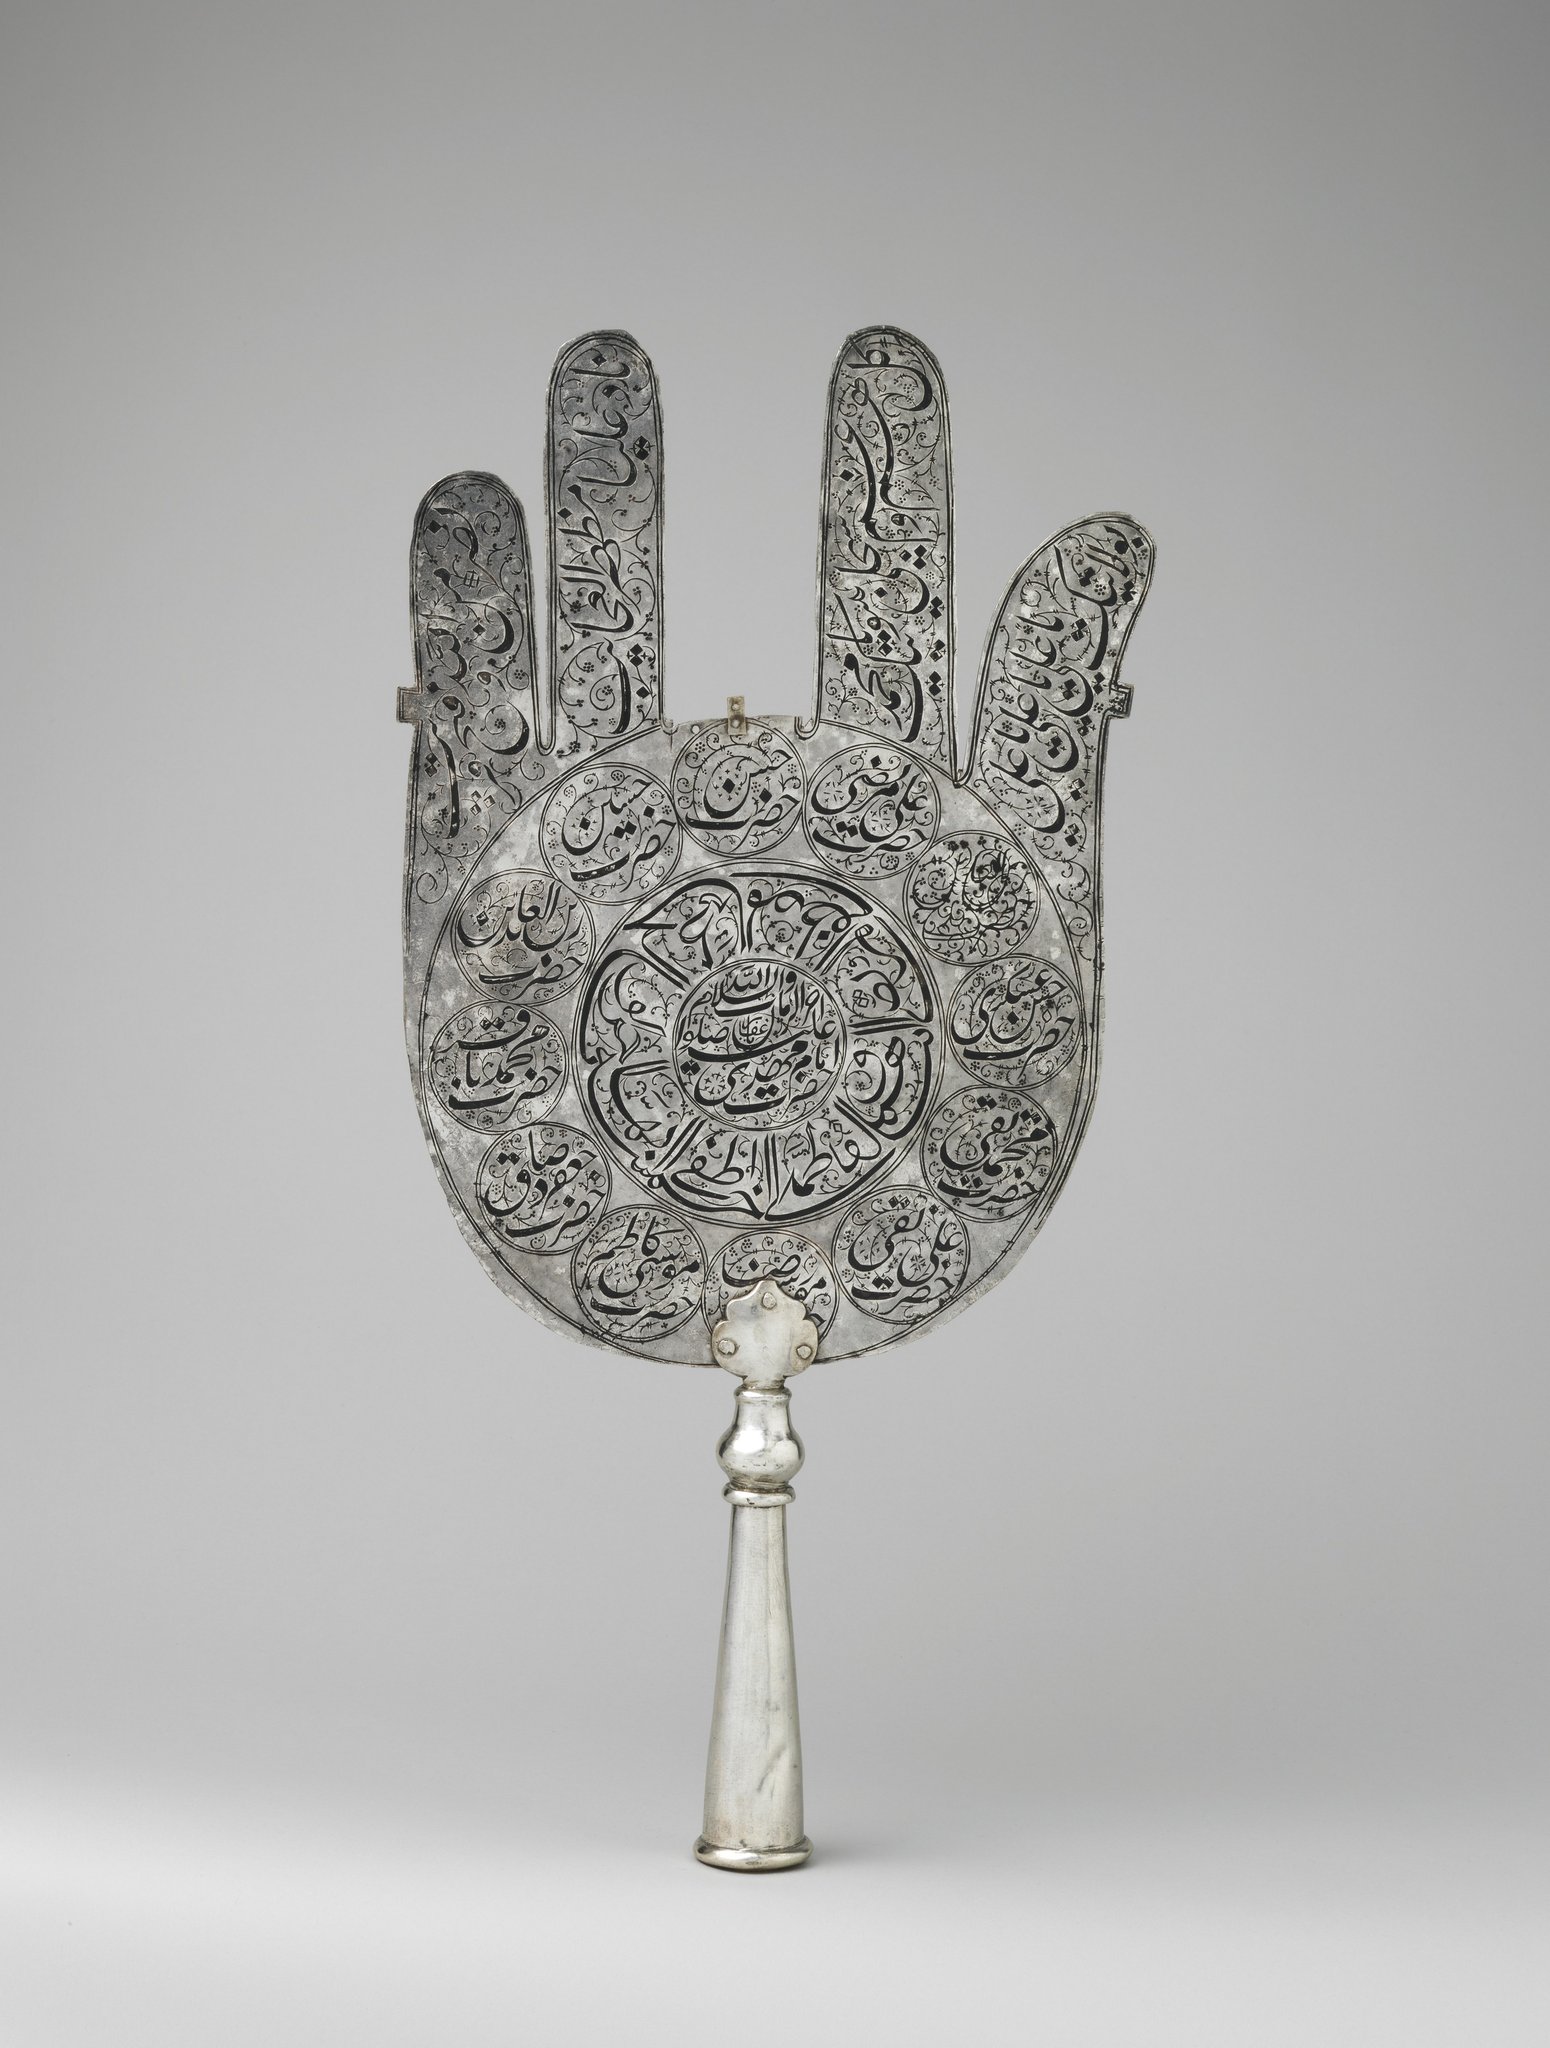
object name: standard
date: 1701-1733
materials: silver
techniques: inlay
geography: iran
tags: hands,arabic